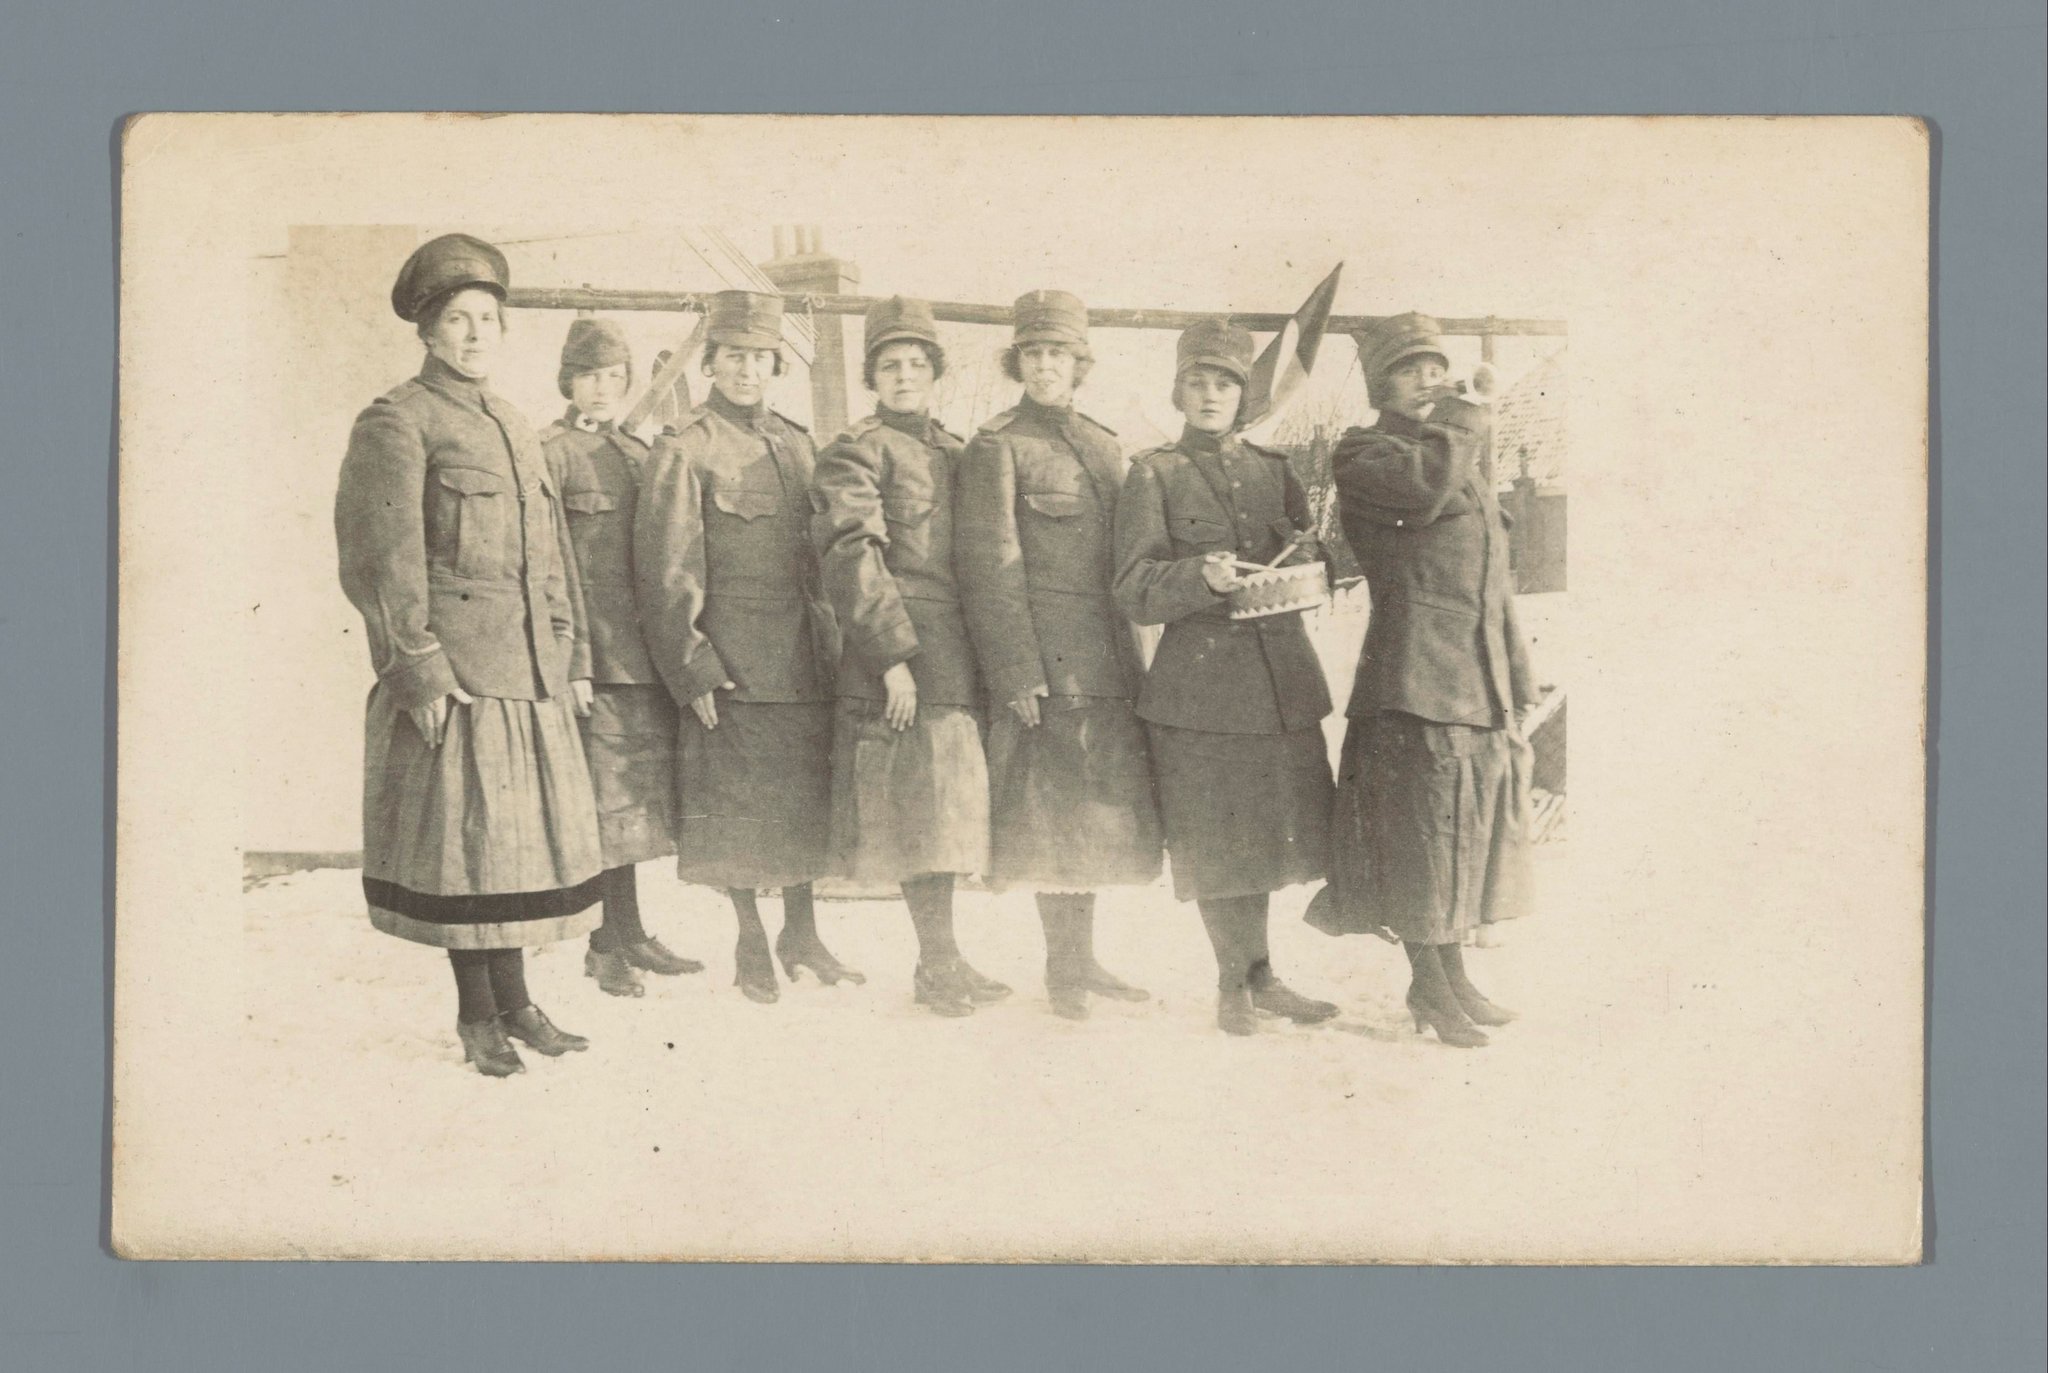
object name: ansichtkaart, prentbriefkaart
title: Groepsportret van zeven onbekende vrouwen in uniform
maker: Anonymous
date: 1907-1920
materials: photographic support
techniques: gelatin silver print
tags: adult woman, (military) uniforms, anonymous historical persons portrayed in a group, in a group-portrait